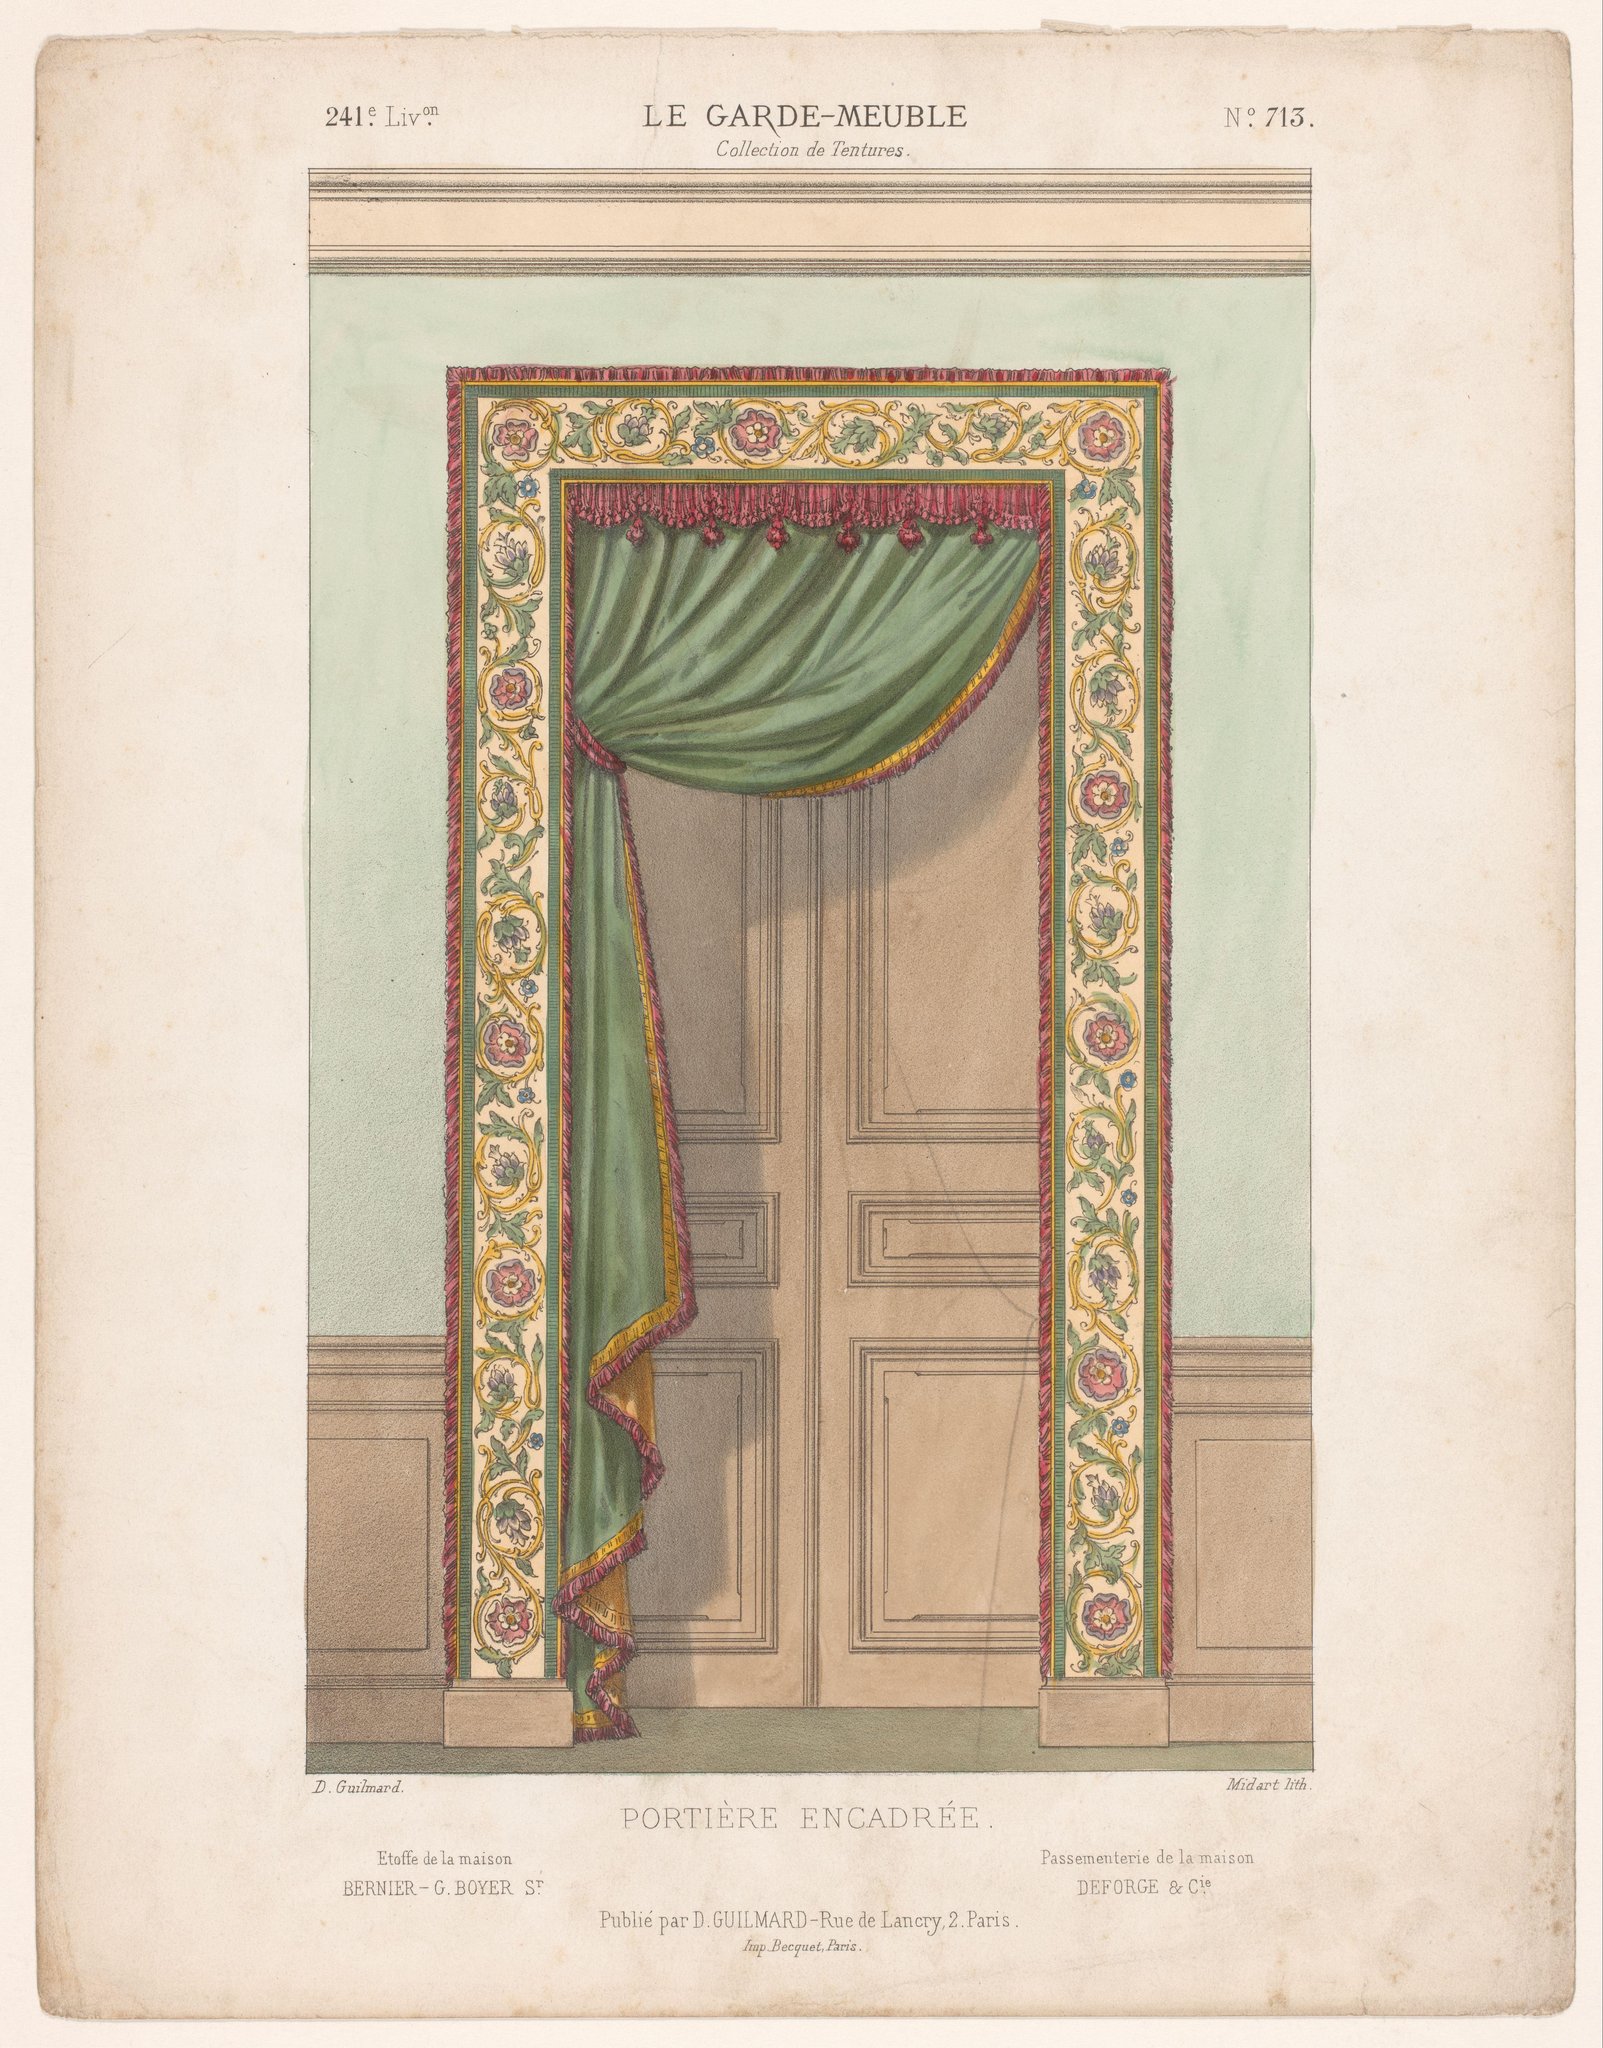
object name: print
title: Portière encadrée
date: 1860-1880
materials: paper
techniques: hand coloring, lithograph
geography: paris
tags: door, hangings and drapery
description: Deur met decoratieve omlijsting en draperie. Prent uit 241e Livraison.